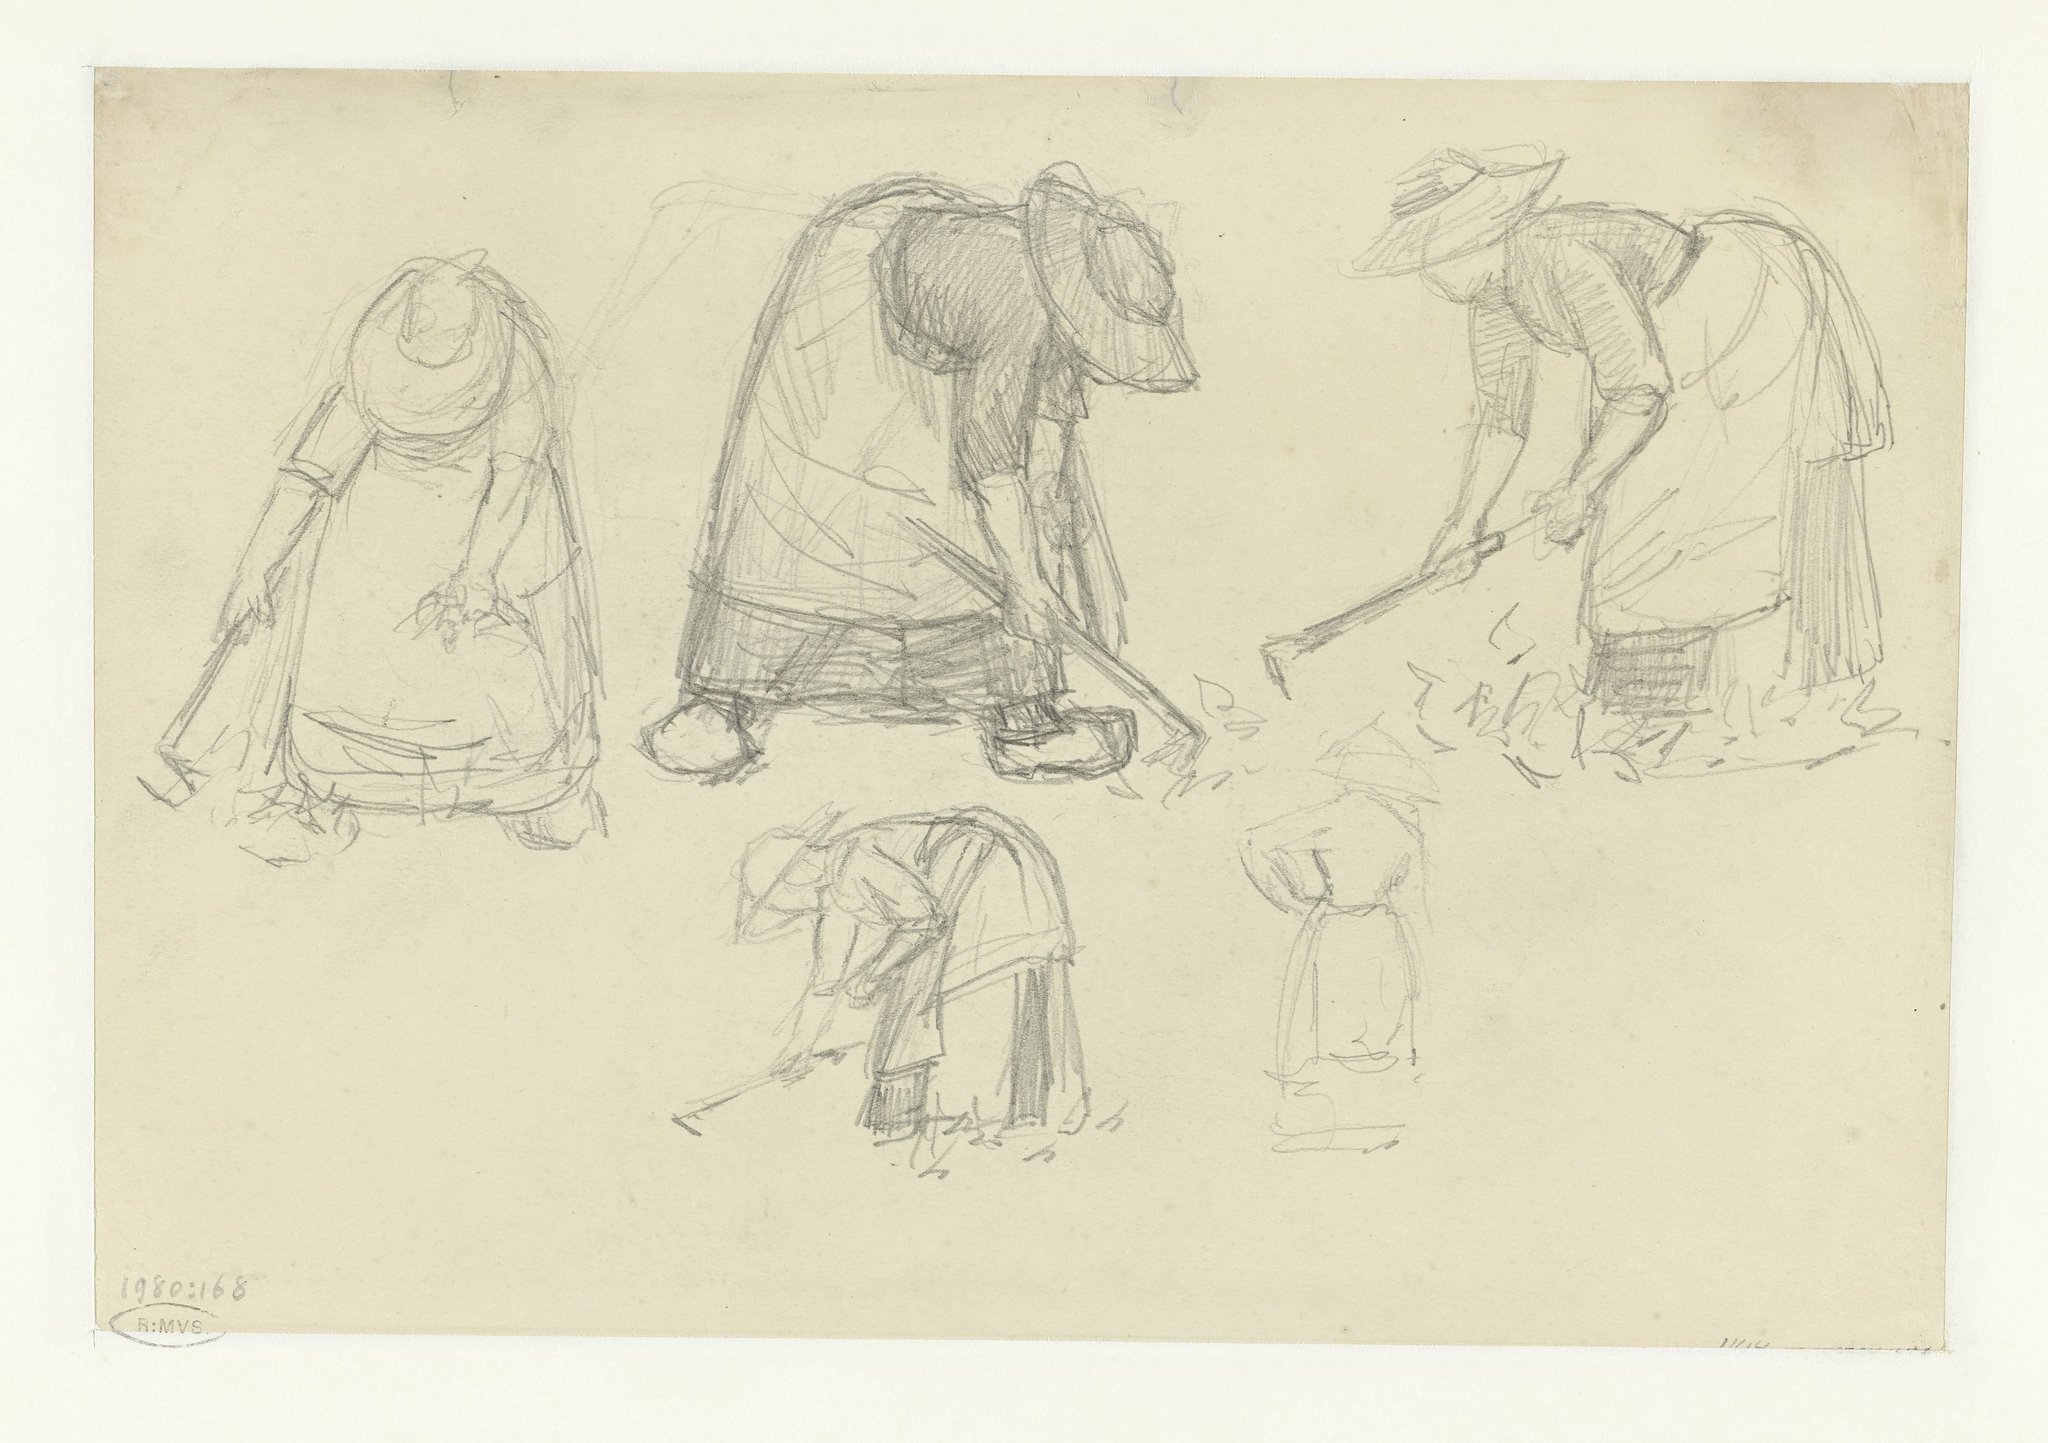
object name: drawing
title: Schetsen van een op het land werkende vrouw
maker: jozef israëls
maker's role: draughtsman, painter, print maker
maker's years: 1824-1911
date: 1834-1911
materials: paper, pencil